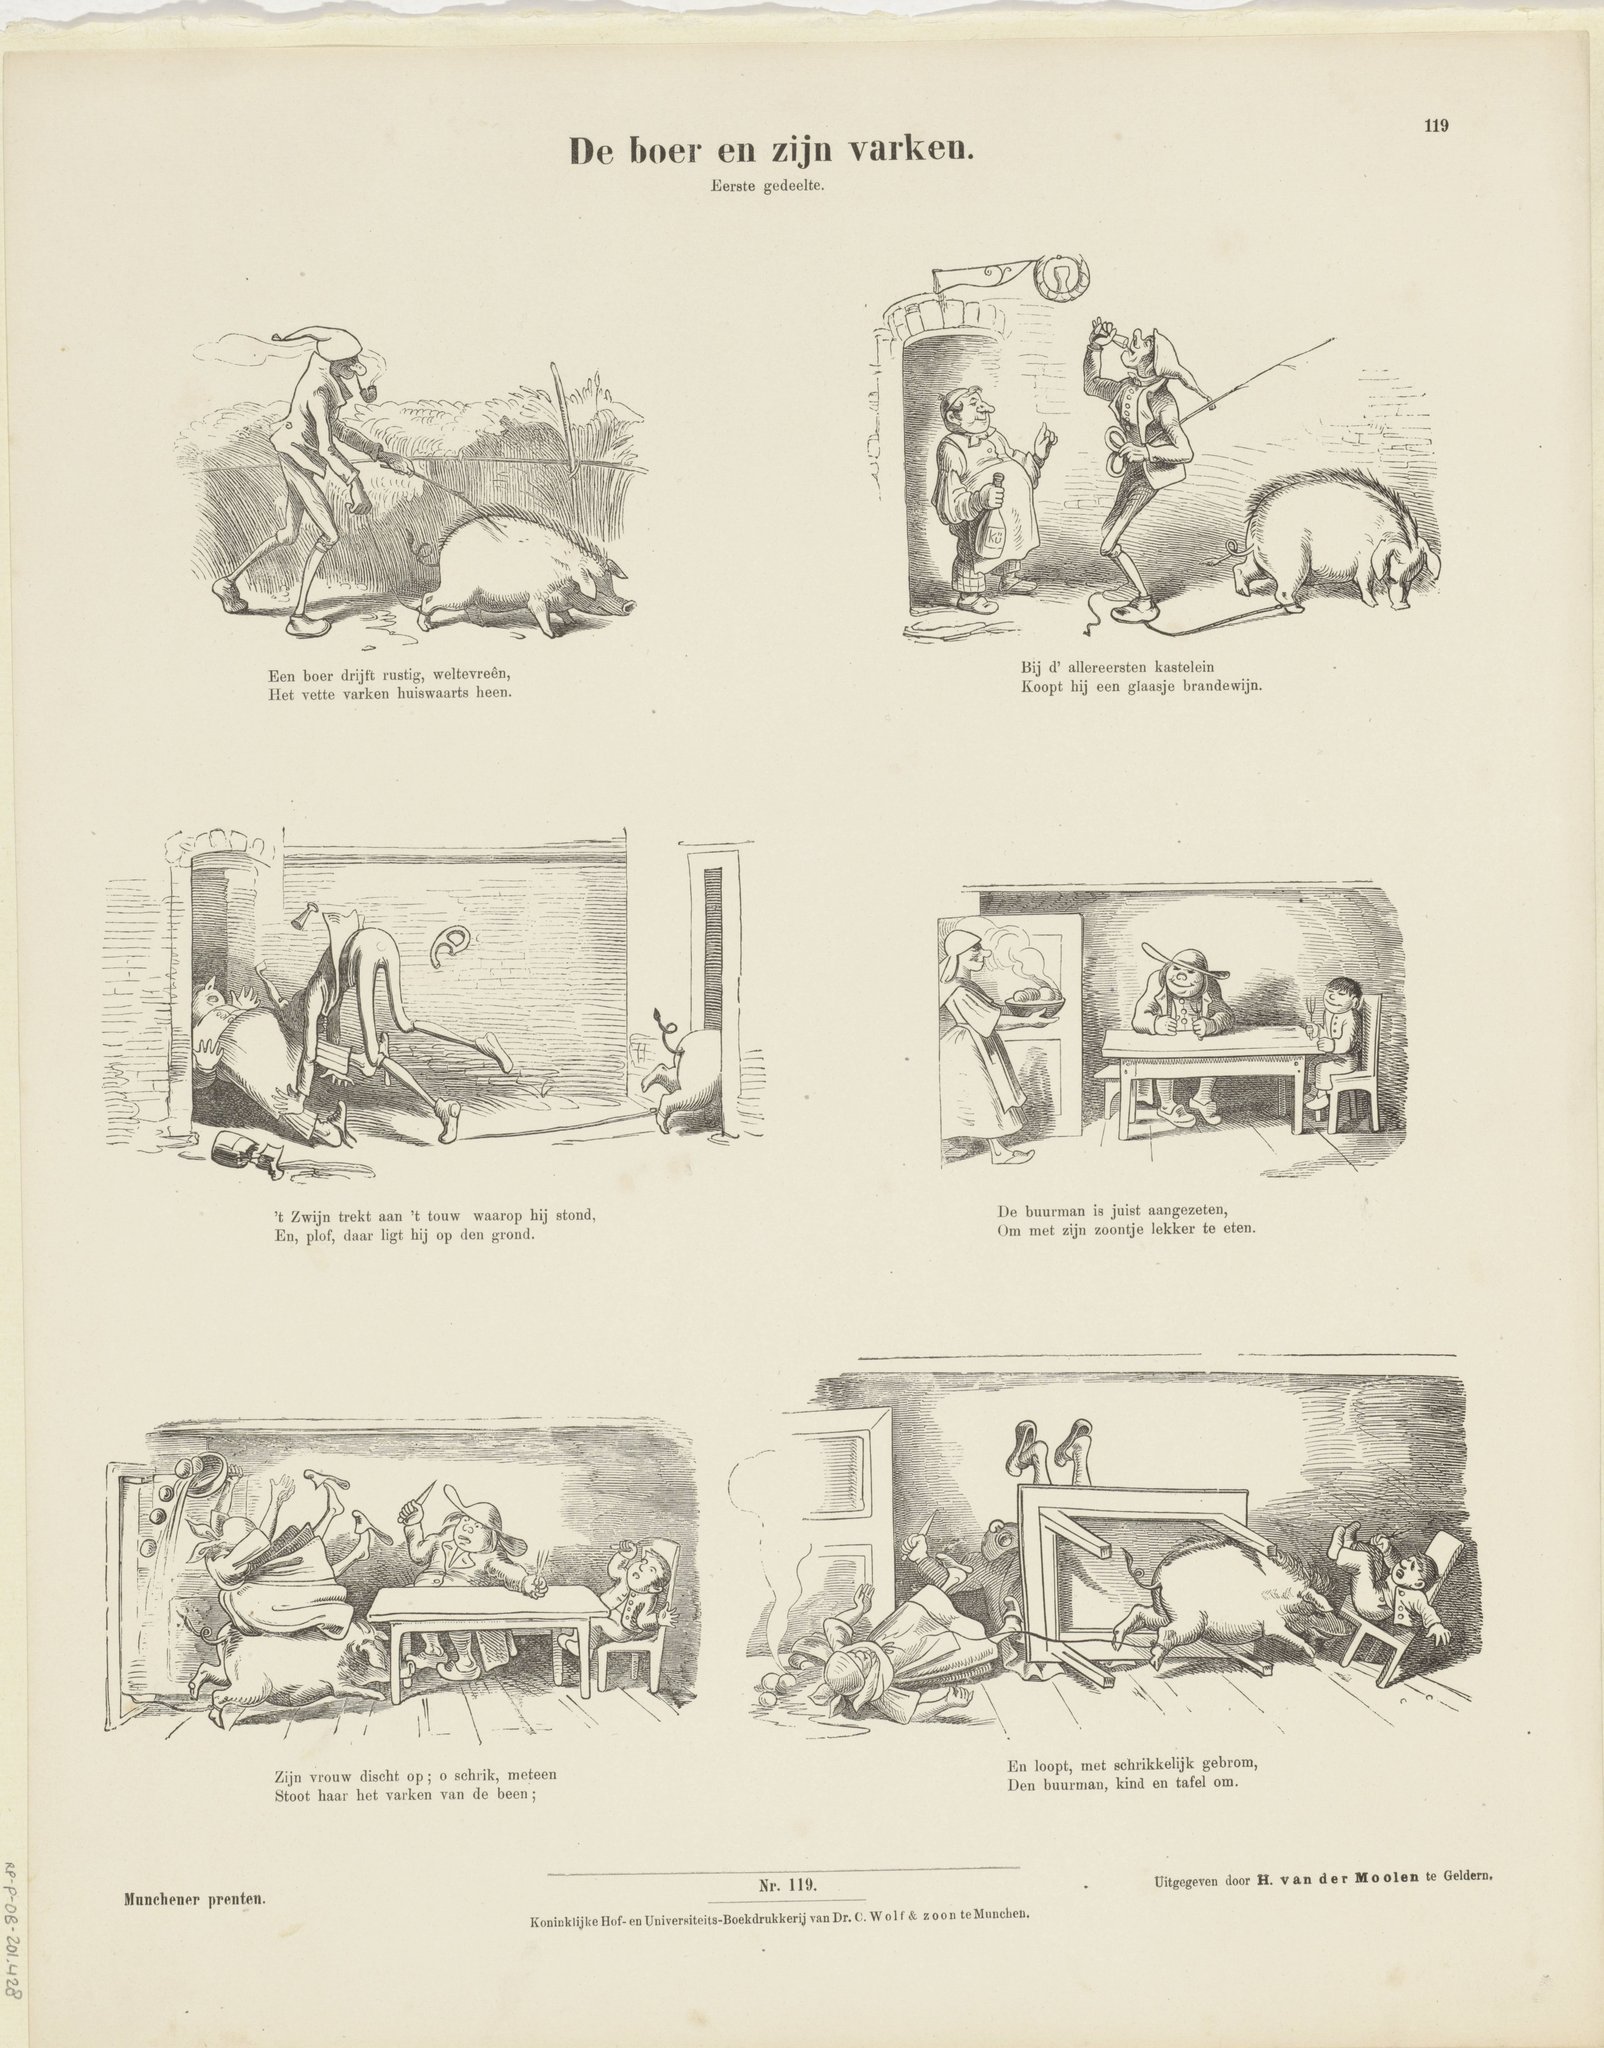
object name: popular print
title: De boer en zijn varken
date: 1843-1920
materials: paper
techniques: letterpress printing, engraving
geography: munich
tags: pig, farmers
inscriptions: collector's mark: Lugt 2760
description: Blad met 6 voorstellingen van een varken die de boel op zijn kop zet bij een boerenfamilie. Onder elke afbeelding een tweeregelig vers. Genummerd midden onder: Nro. 119. Genummerd rechtsboven: 119.